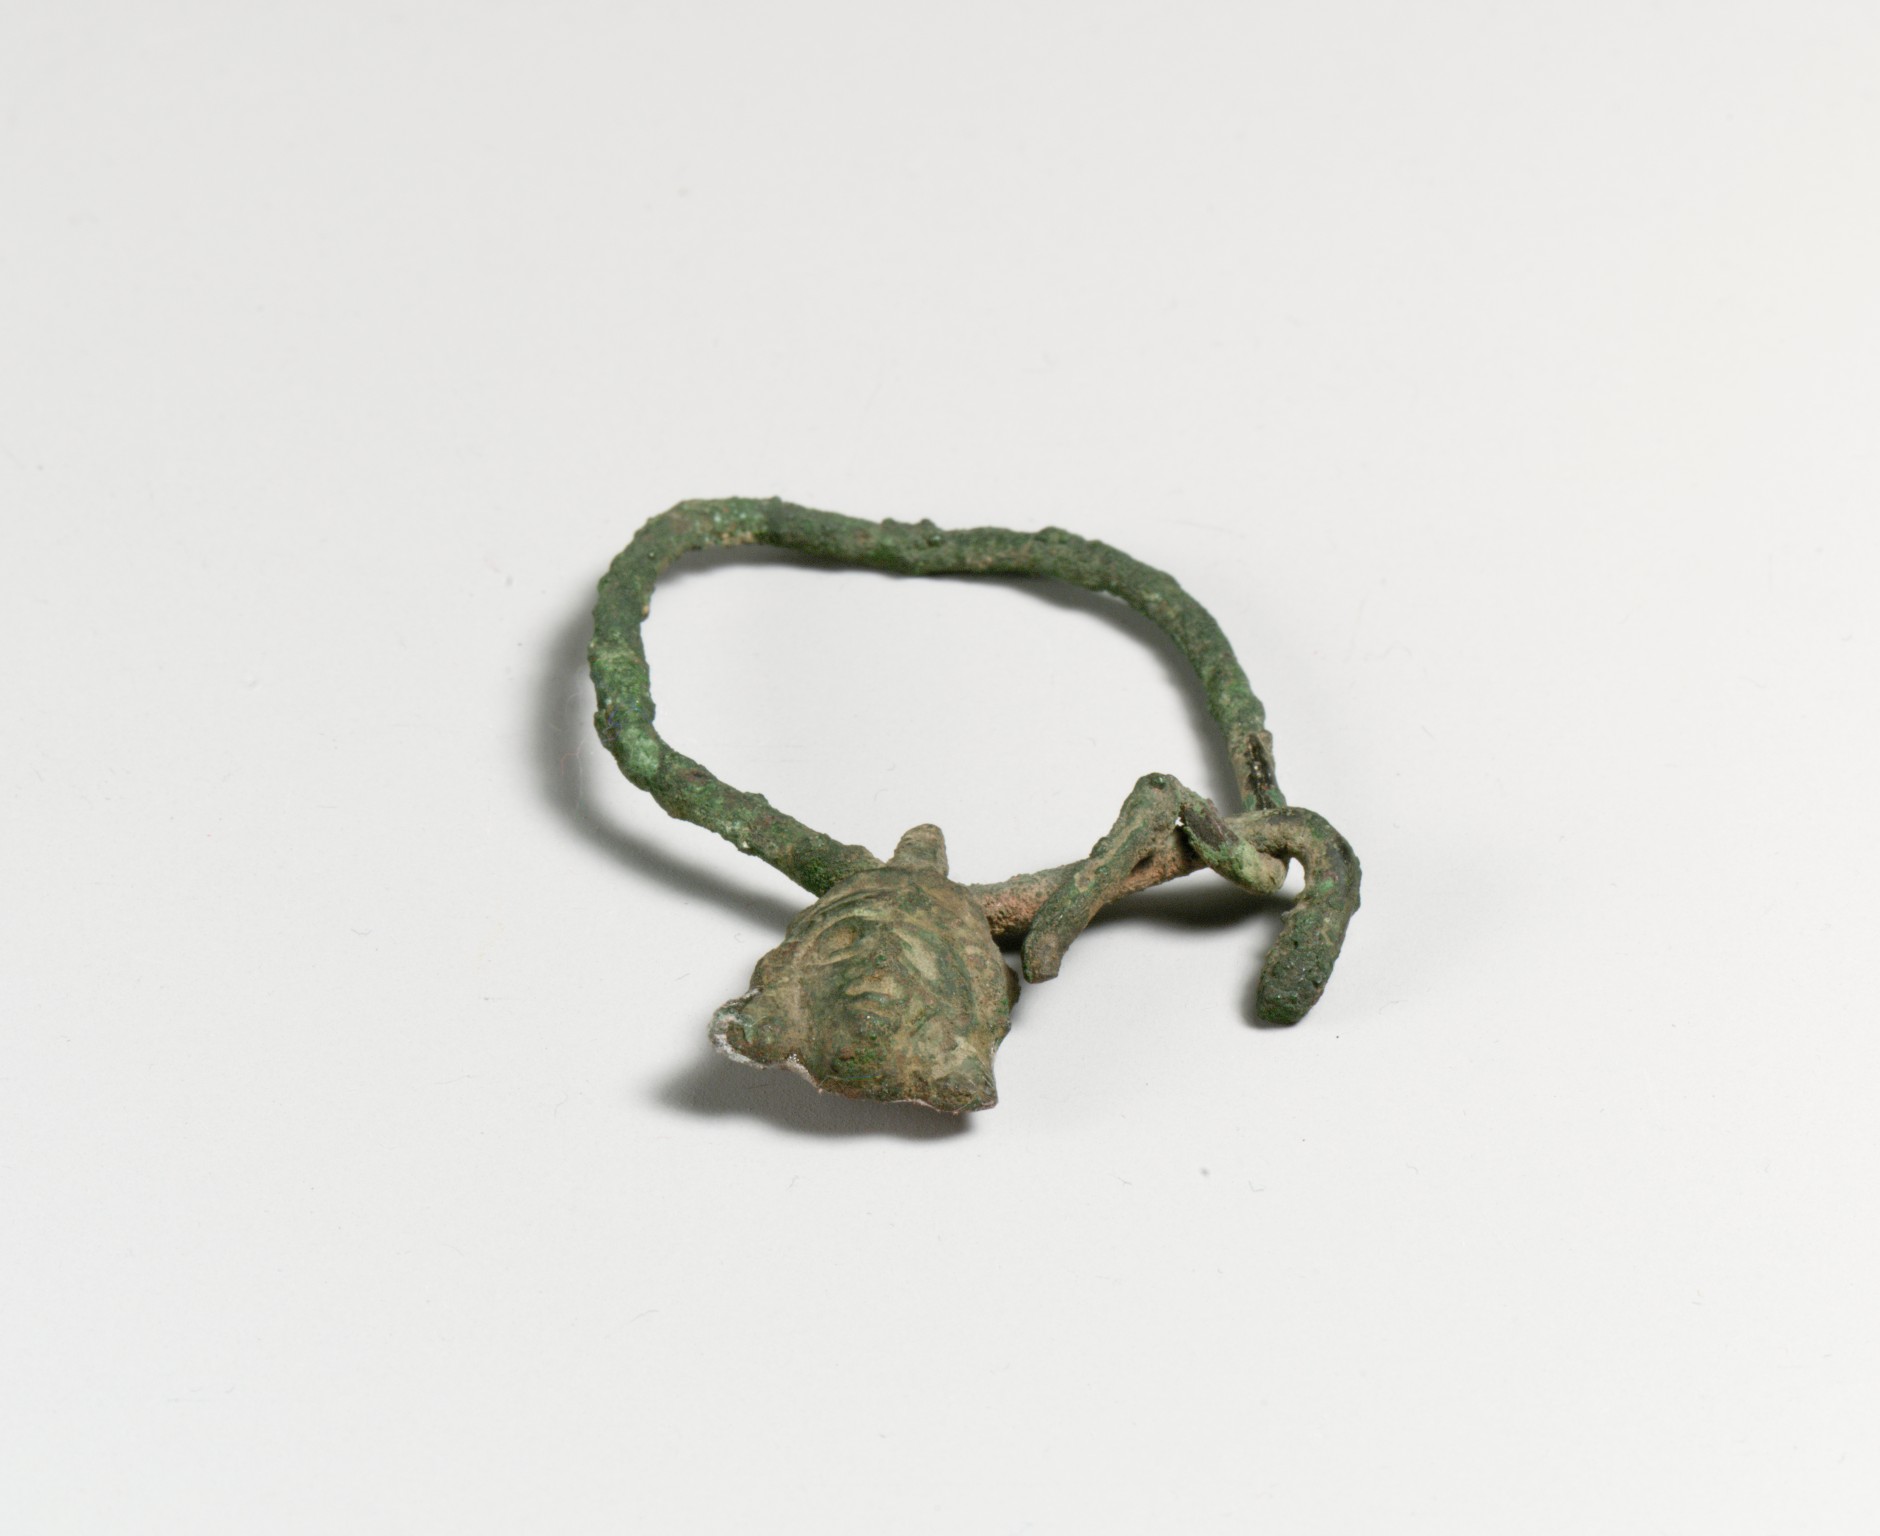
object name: earring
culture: cypriot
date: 3900 BCE-100 CE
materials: bronze